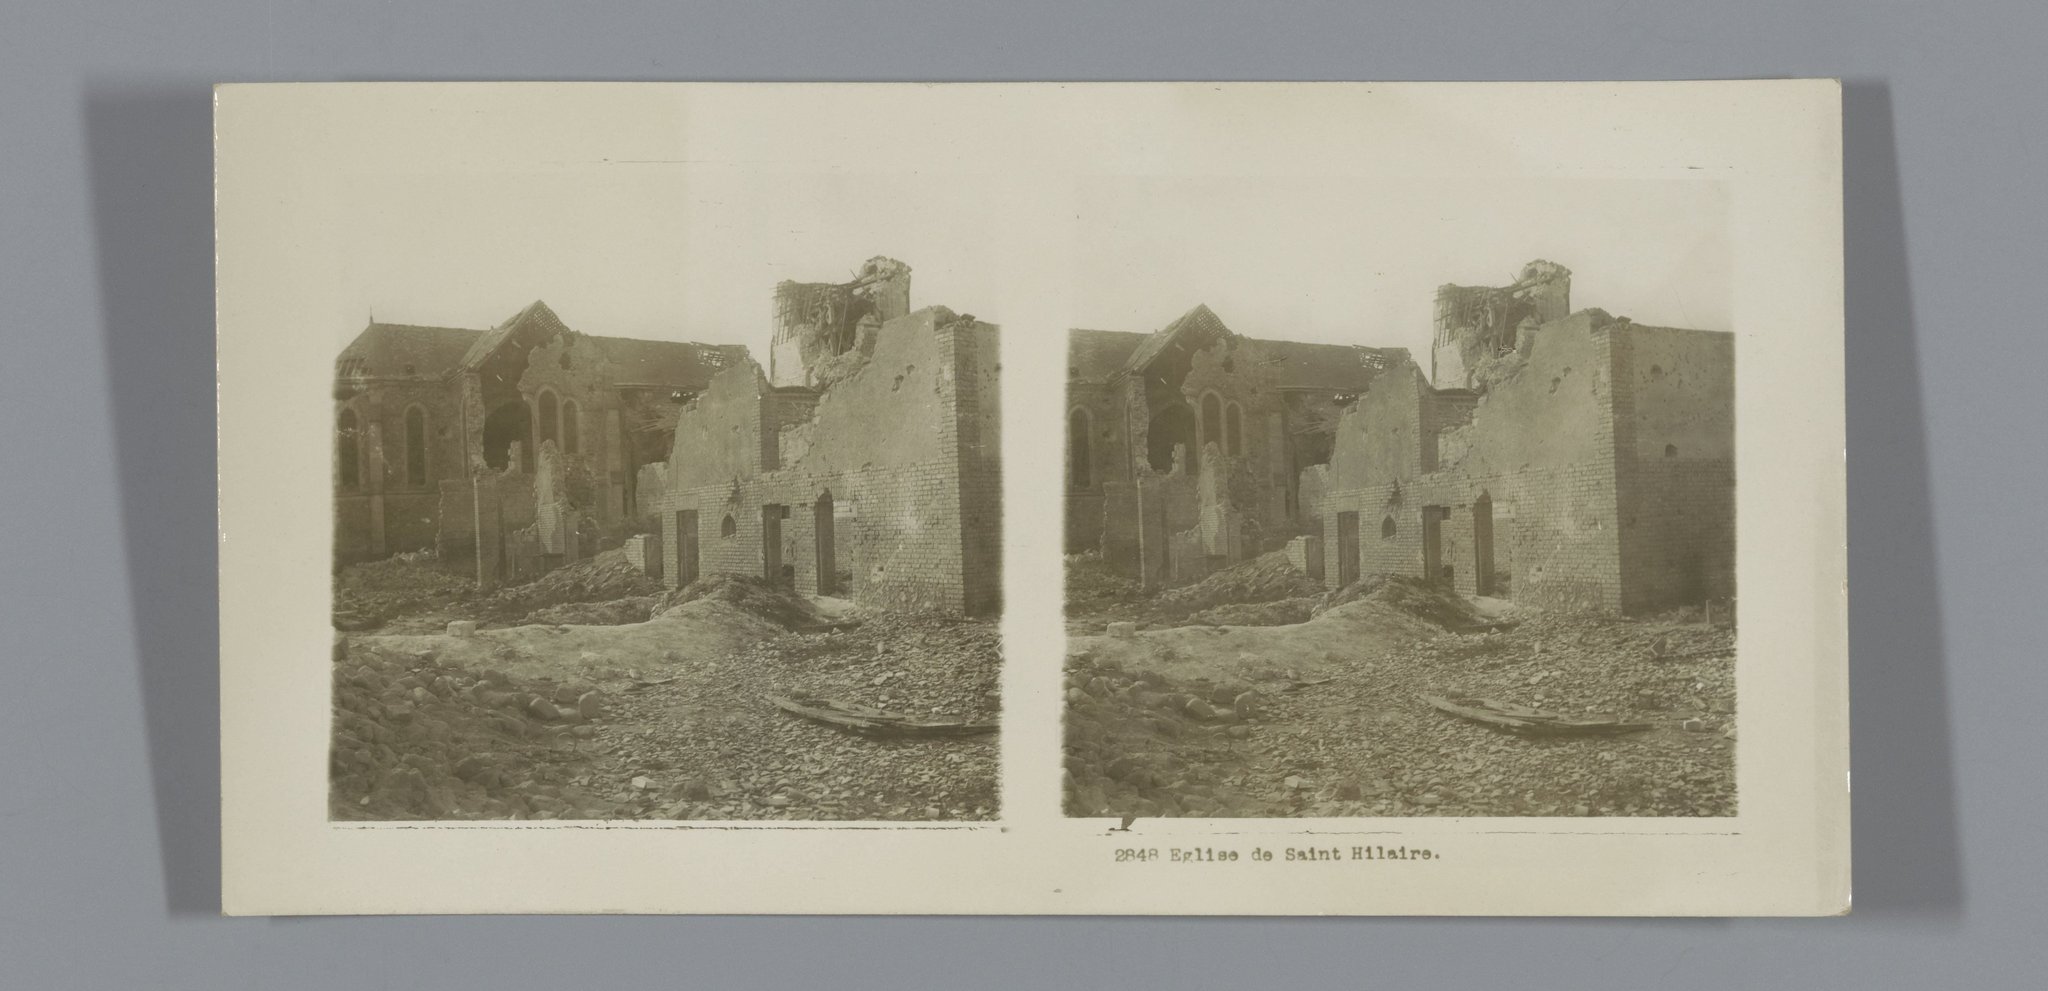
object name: stereograph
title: Ruïne van de Kerk van Saint-Hilaire-le-Grand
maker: Anonymous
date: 1914-1918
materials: cardboard, photographic support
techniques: gelatin silver print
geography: saint-hilaire-le-grand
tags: ruin of church, monastery, etc.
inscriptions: number: ‘2848’